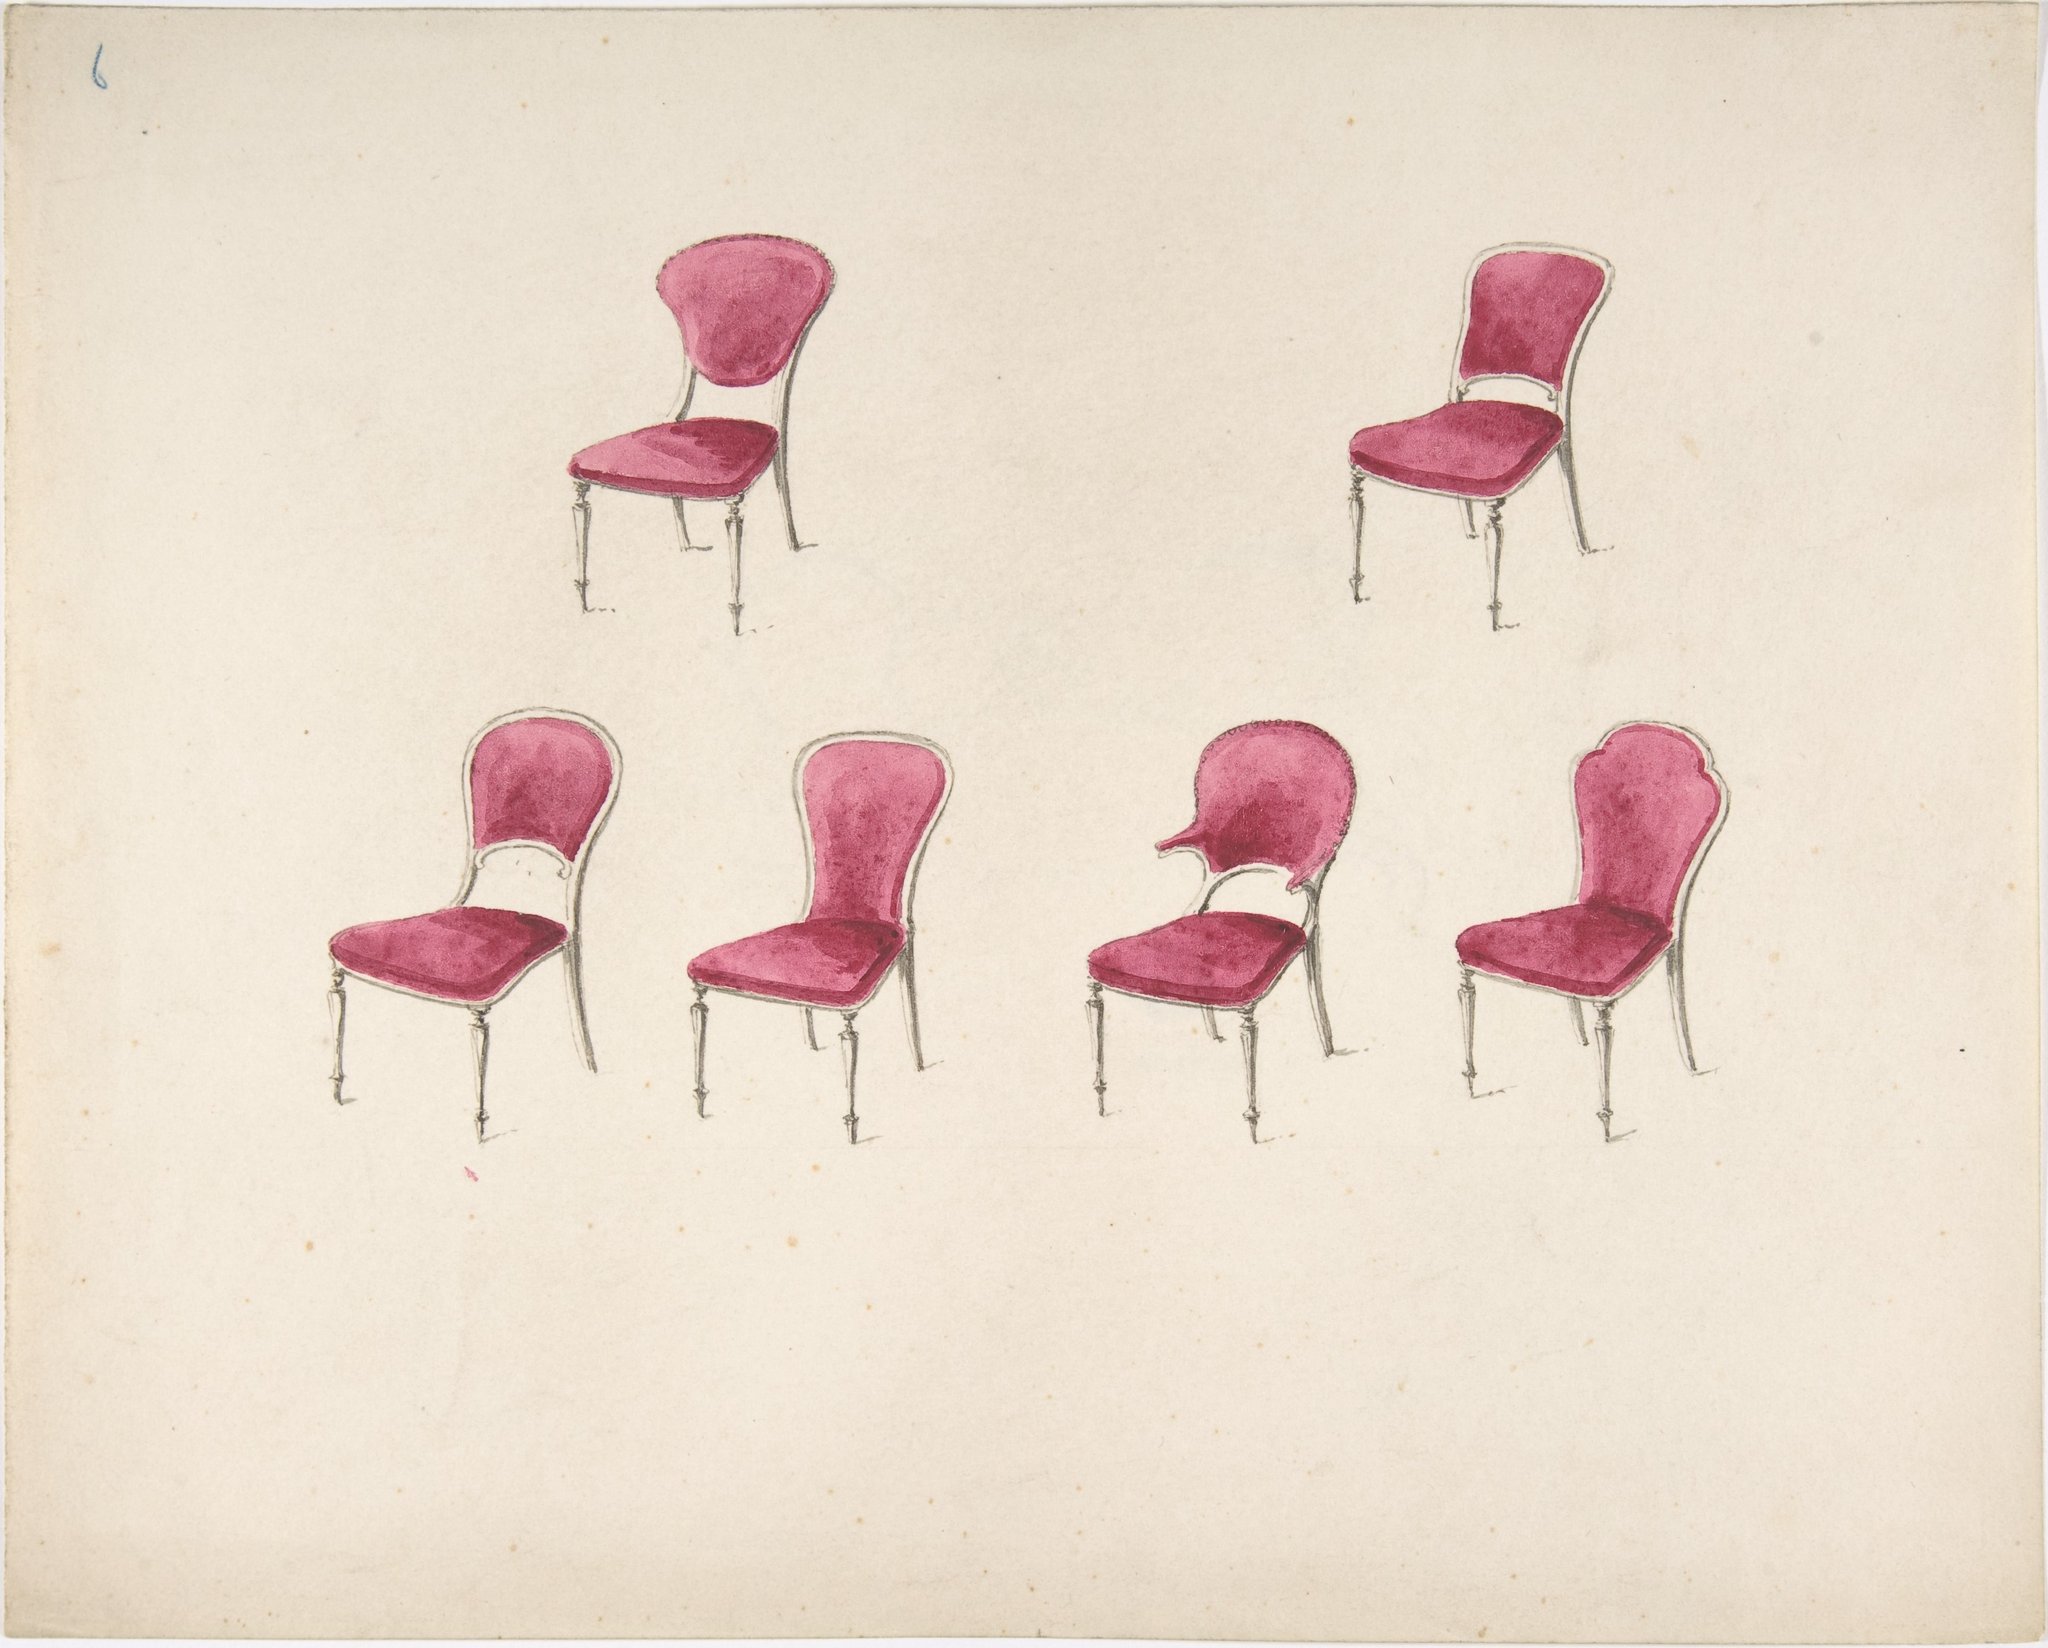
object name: drawing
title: Design for Six Chairs with Scarlet Upholstery (verso: Sketch for Sofa)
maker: anonymous, british, 19th century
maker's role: artist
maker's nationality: british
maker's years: 1800-1900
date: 1801-1833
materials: graphite, ink, watercolor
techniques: brush, pen, wash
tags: chairs